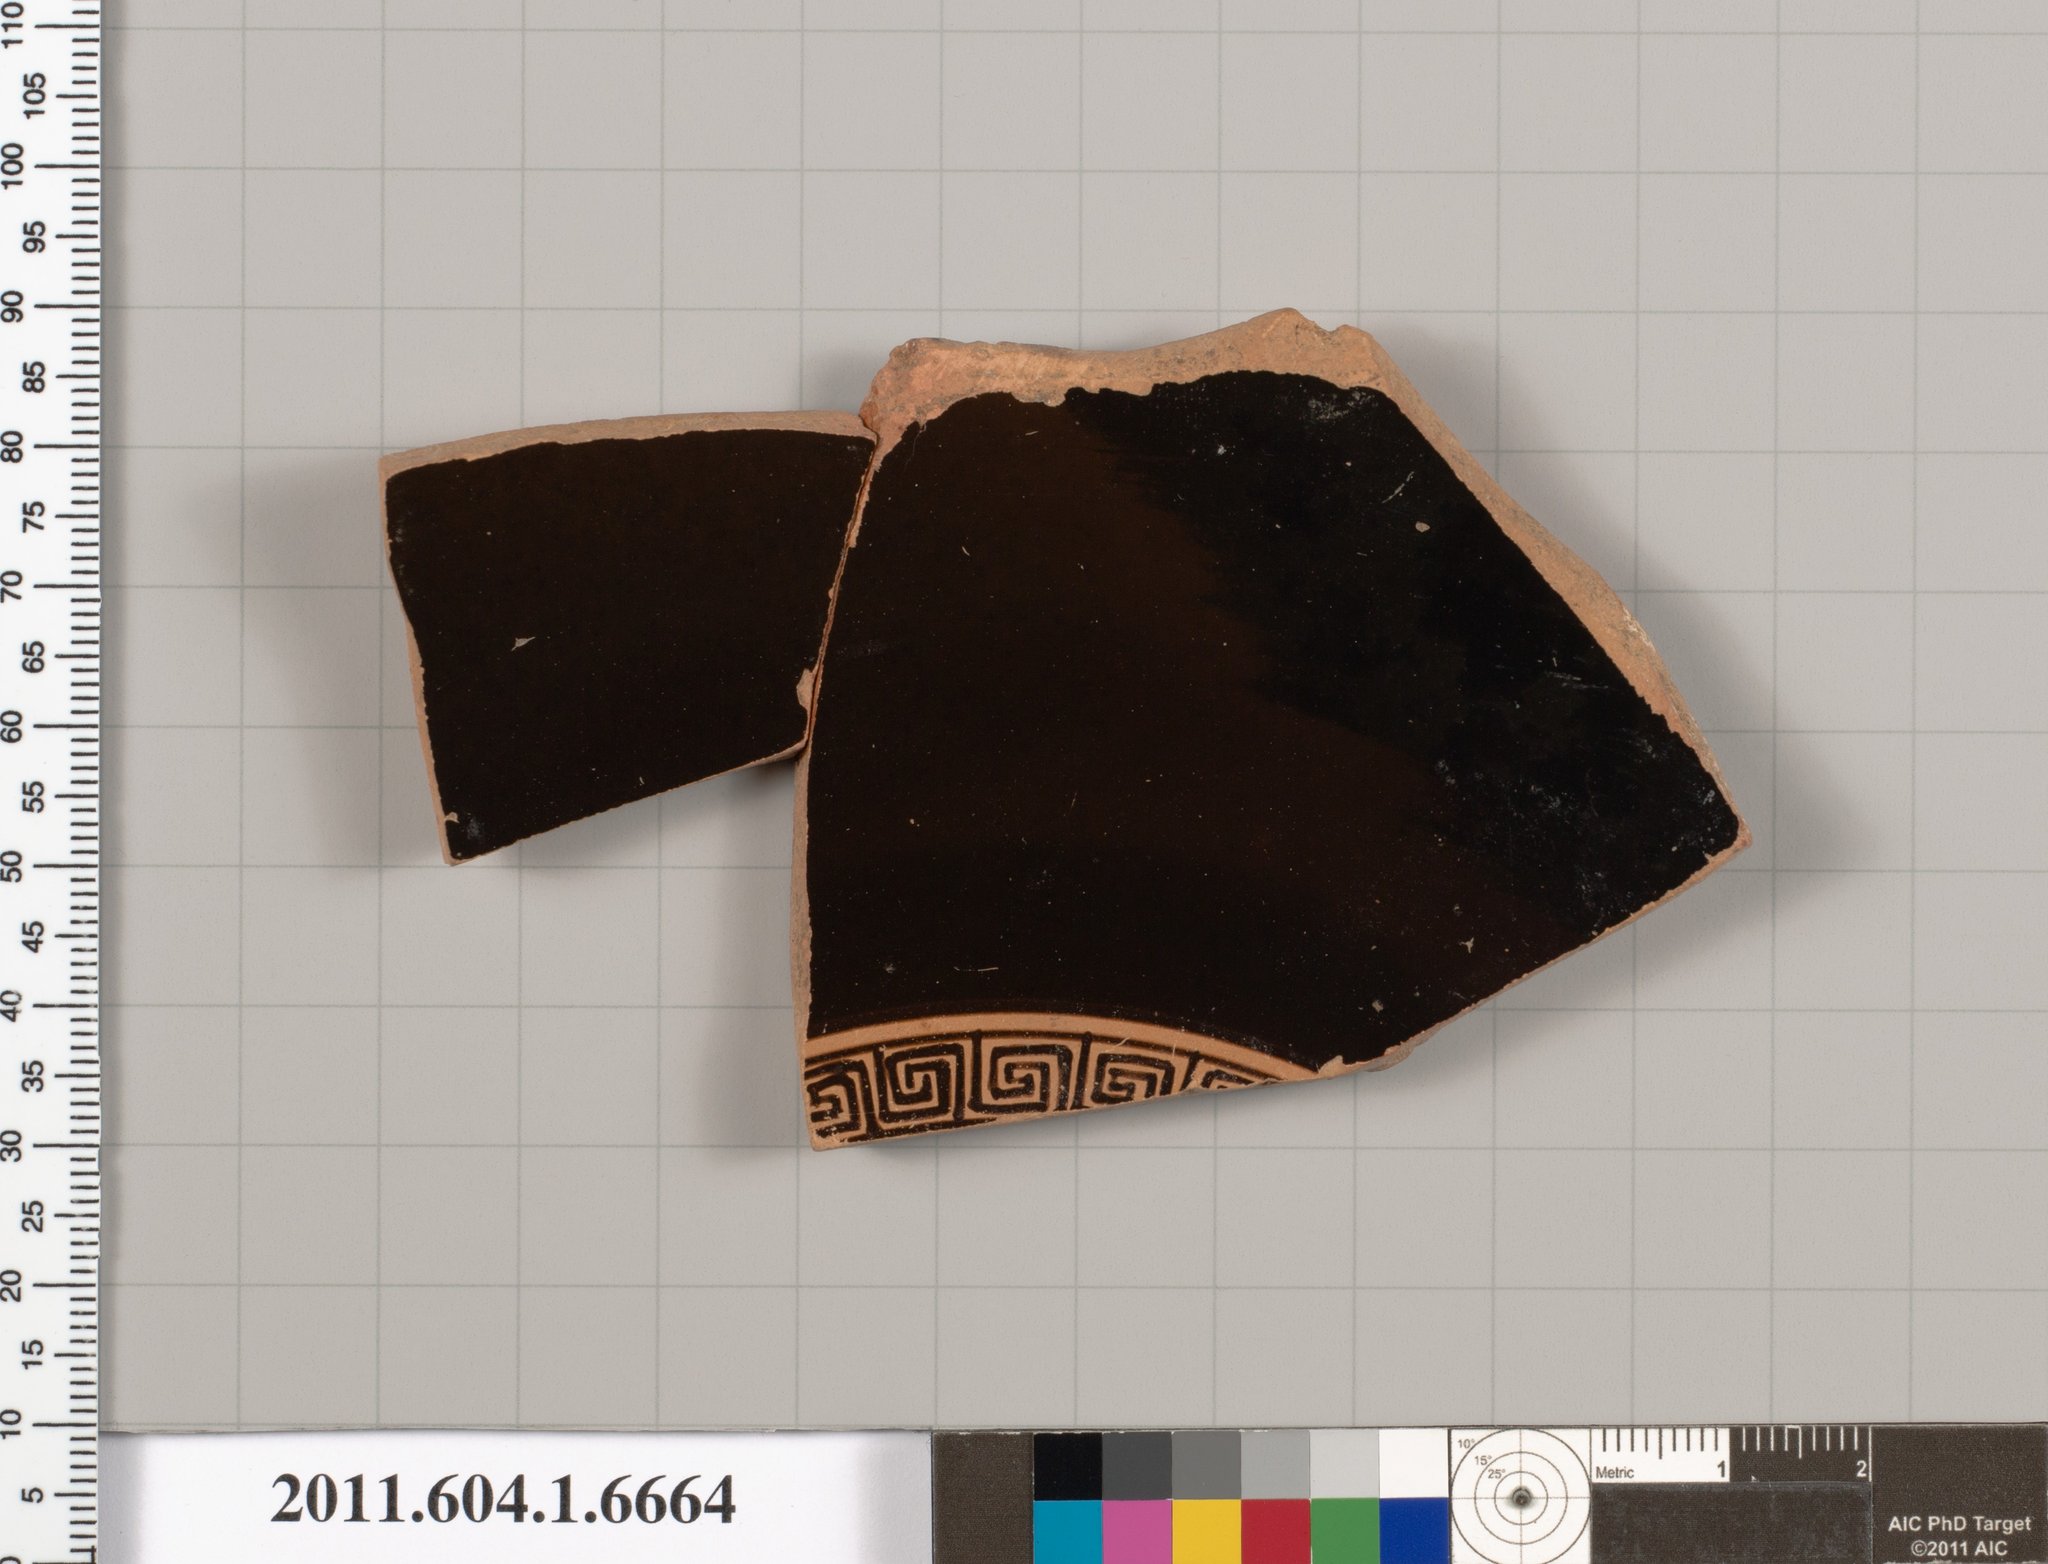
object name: kylix fragment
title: Terracotta fragment of a kylix (drinking cup)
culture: greek, attic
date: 490-470 BCE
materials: terracotta